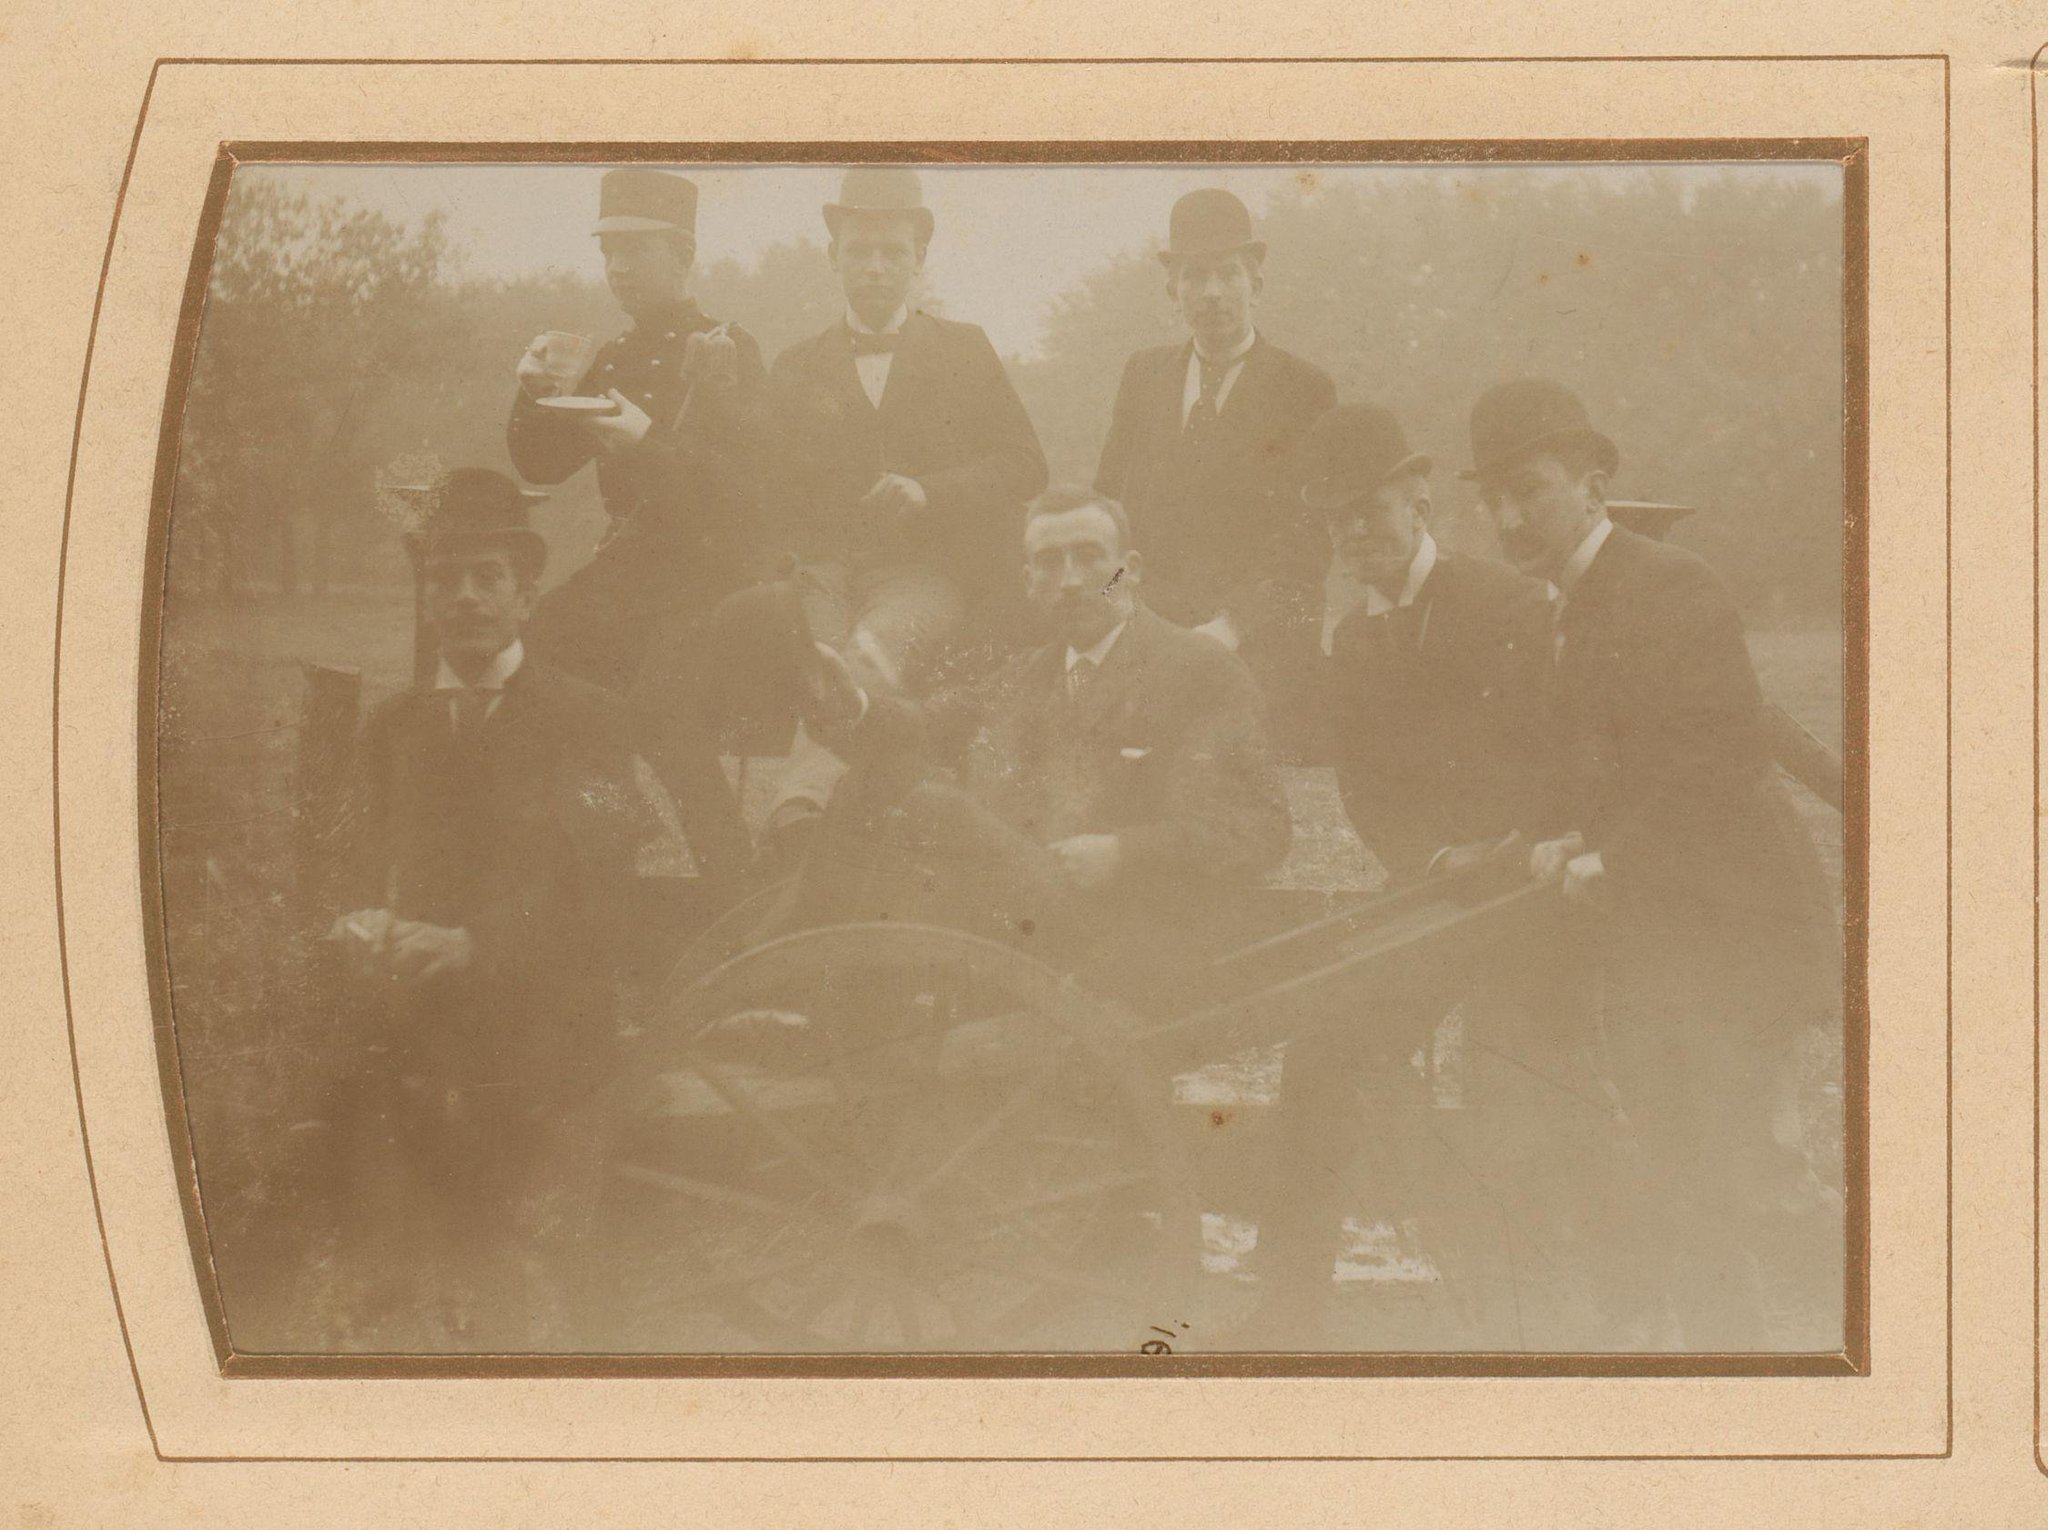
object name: photograph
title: Studenten rondom een houten trekkar, rechts achter de kar François Buys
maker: Anonymous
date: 1880-1890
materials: paper, cardboard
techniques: collodion silver print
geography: amsterdam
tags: françois buys, hand-cart, historical persons, student life, anonymous historical persons portrayed in a group, in a group-portrait